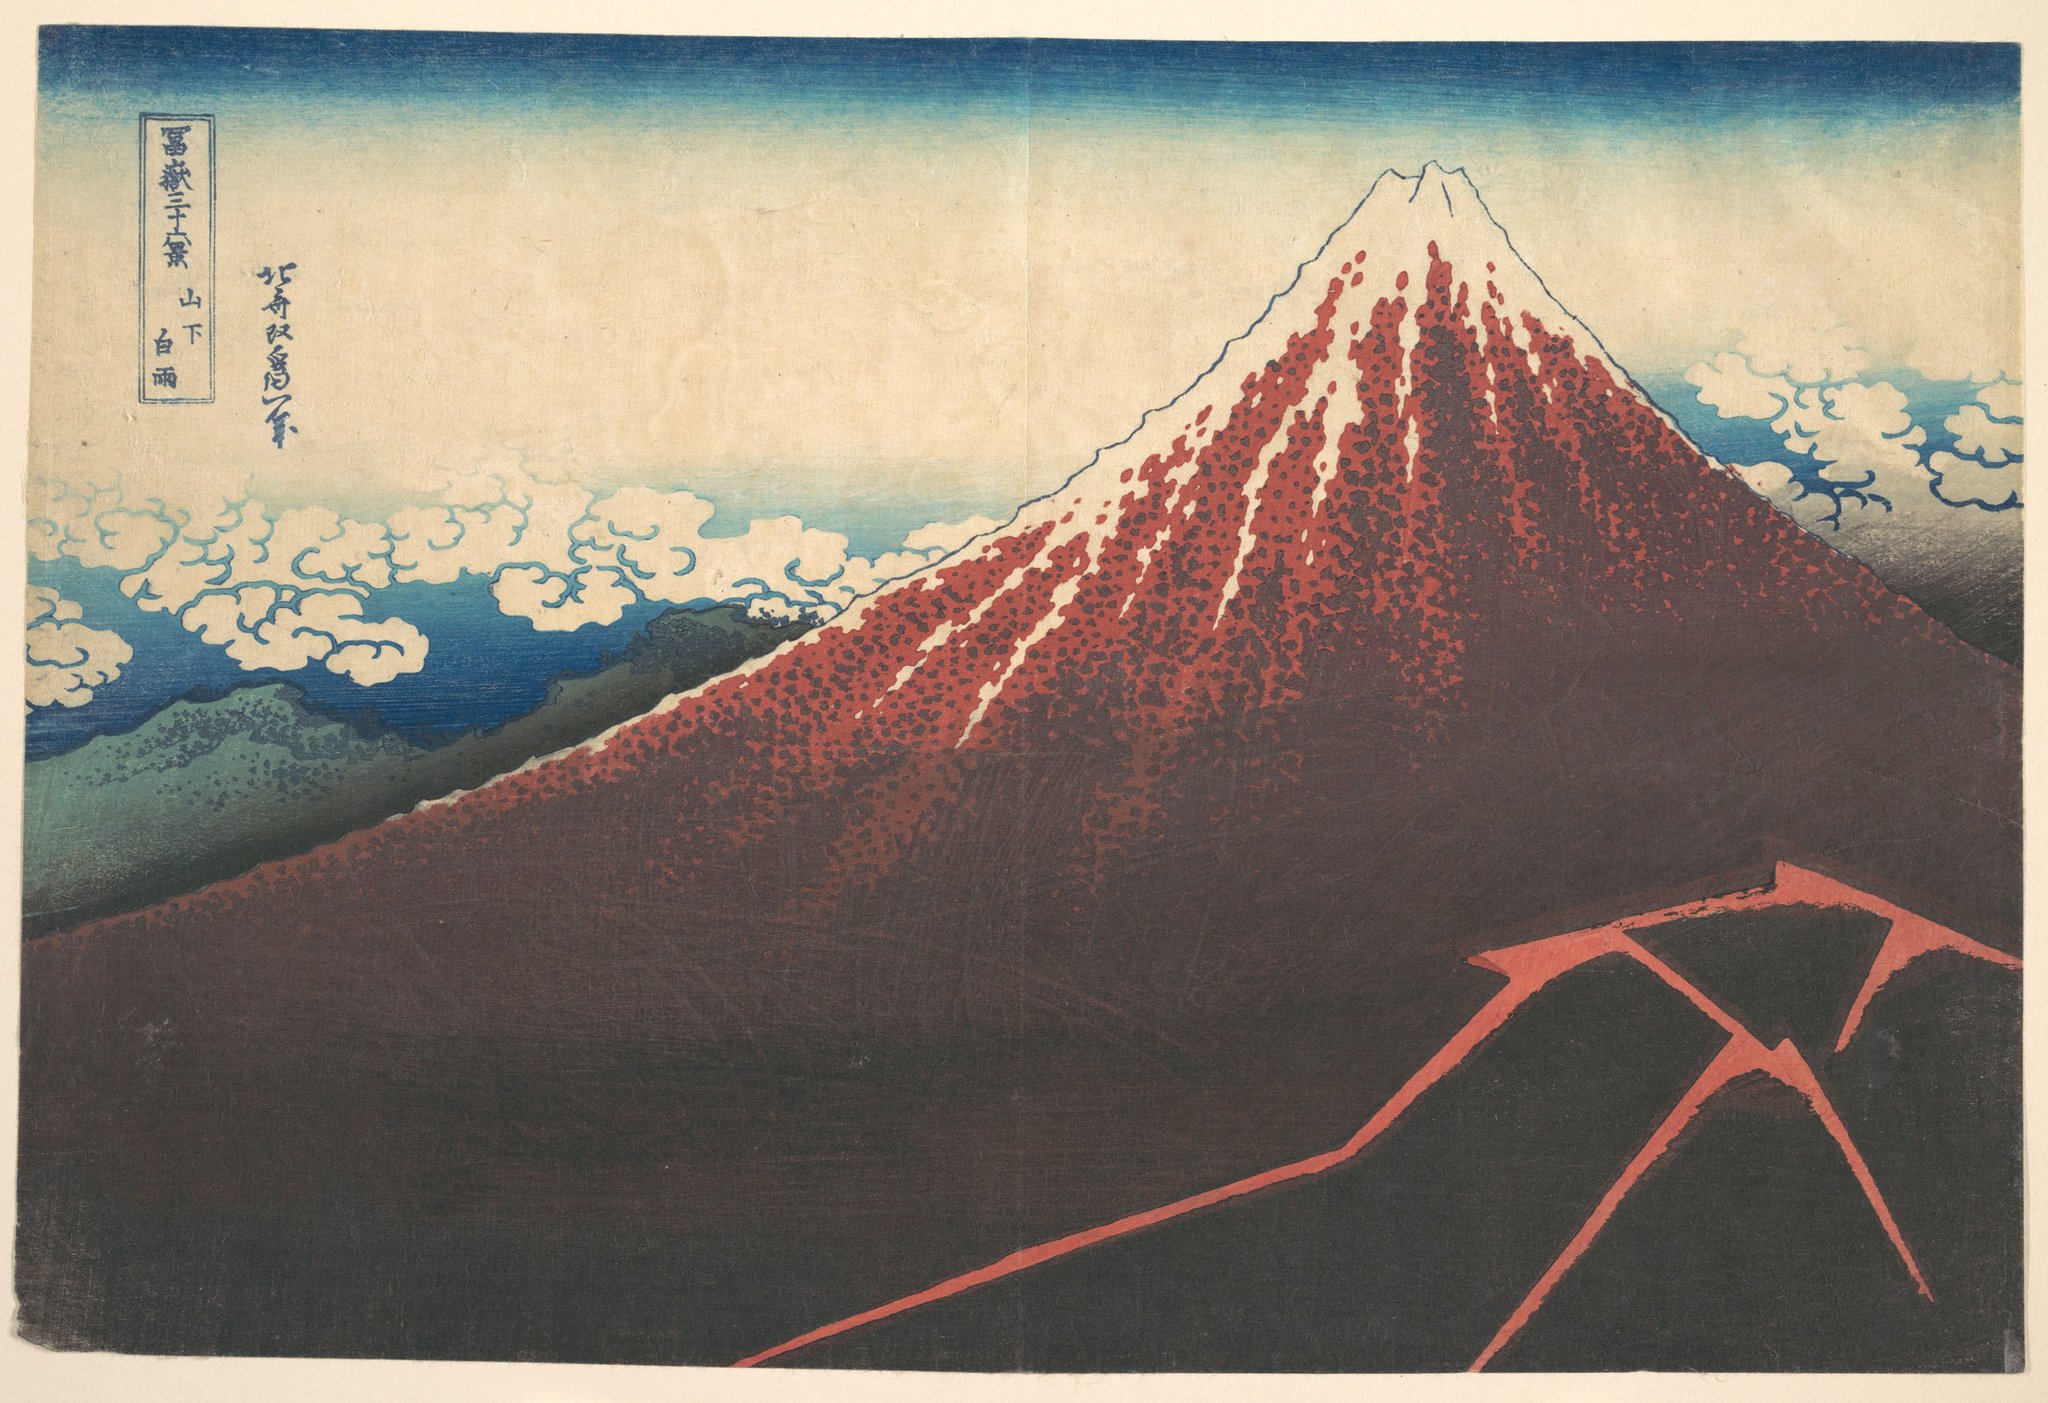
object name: woodblock print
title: Storm below Mount Fuji (Sanka no haku u), from the series Thirty-six Views of Mount Fuji (Fugaku sanjūrokkei)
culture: japanese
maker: katsushika hokusai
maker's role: artist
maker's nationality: japanese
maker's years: 1760-1849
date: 1830-1832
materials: ink, paper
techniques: woodblock print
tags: mountains,volcanoes